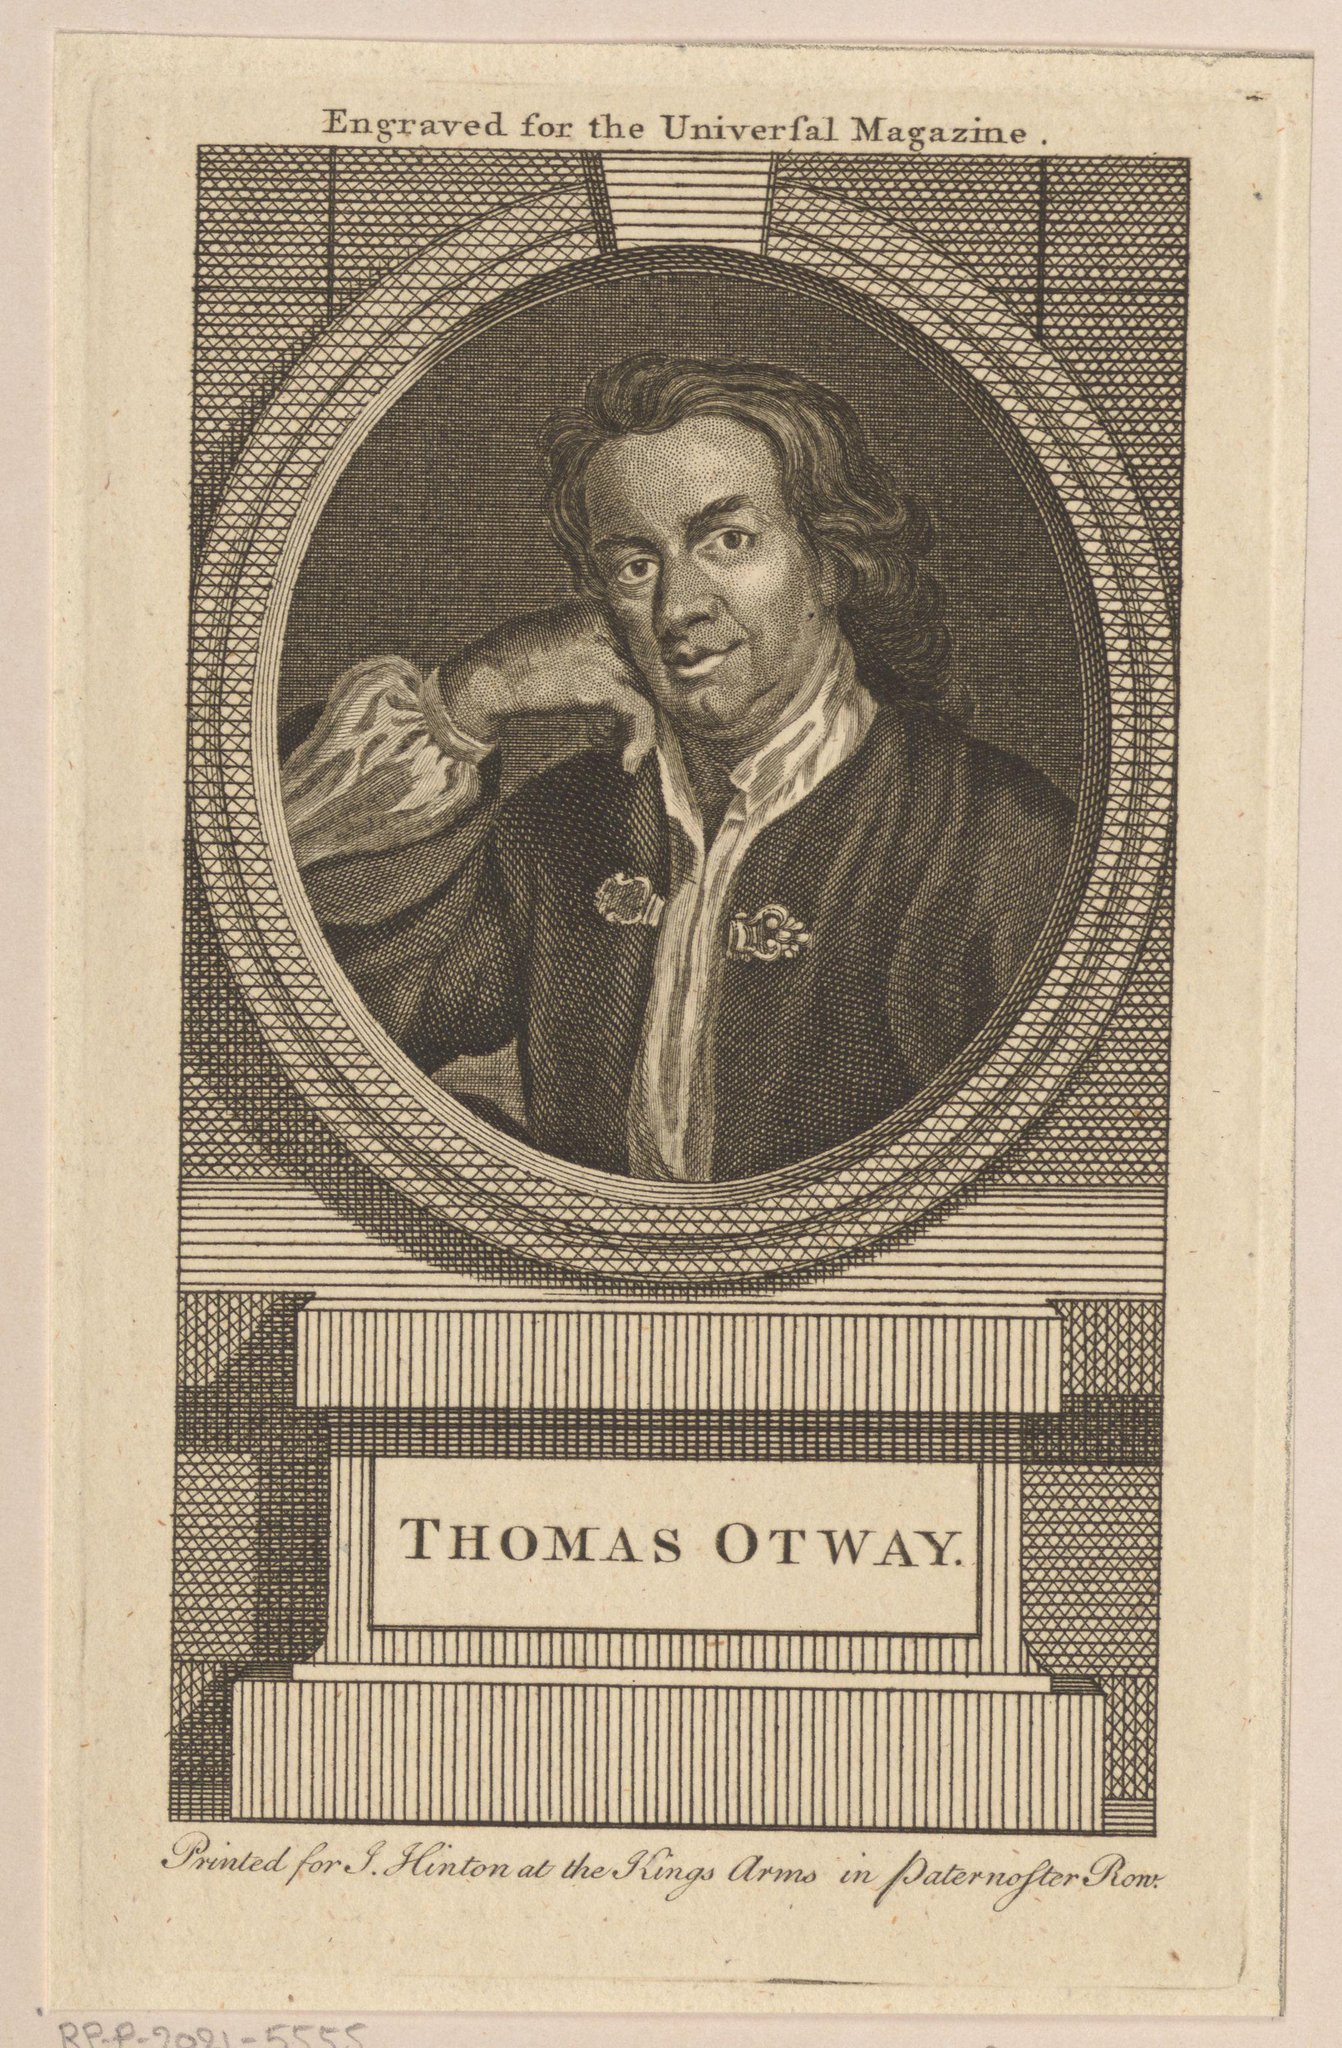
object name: print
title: Portret van Thomas Otway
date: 1747-1781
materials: paper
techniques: engraving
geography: london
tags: historical persons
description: Prent uit: Universal Magazine, uitgegeven tussen 1747-1814.